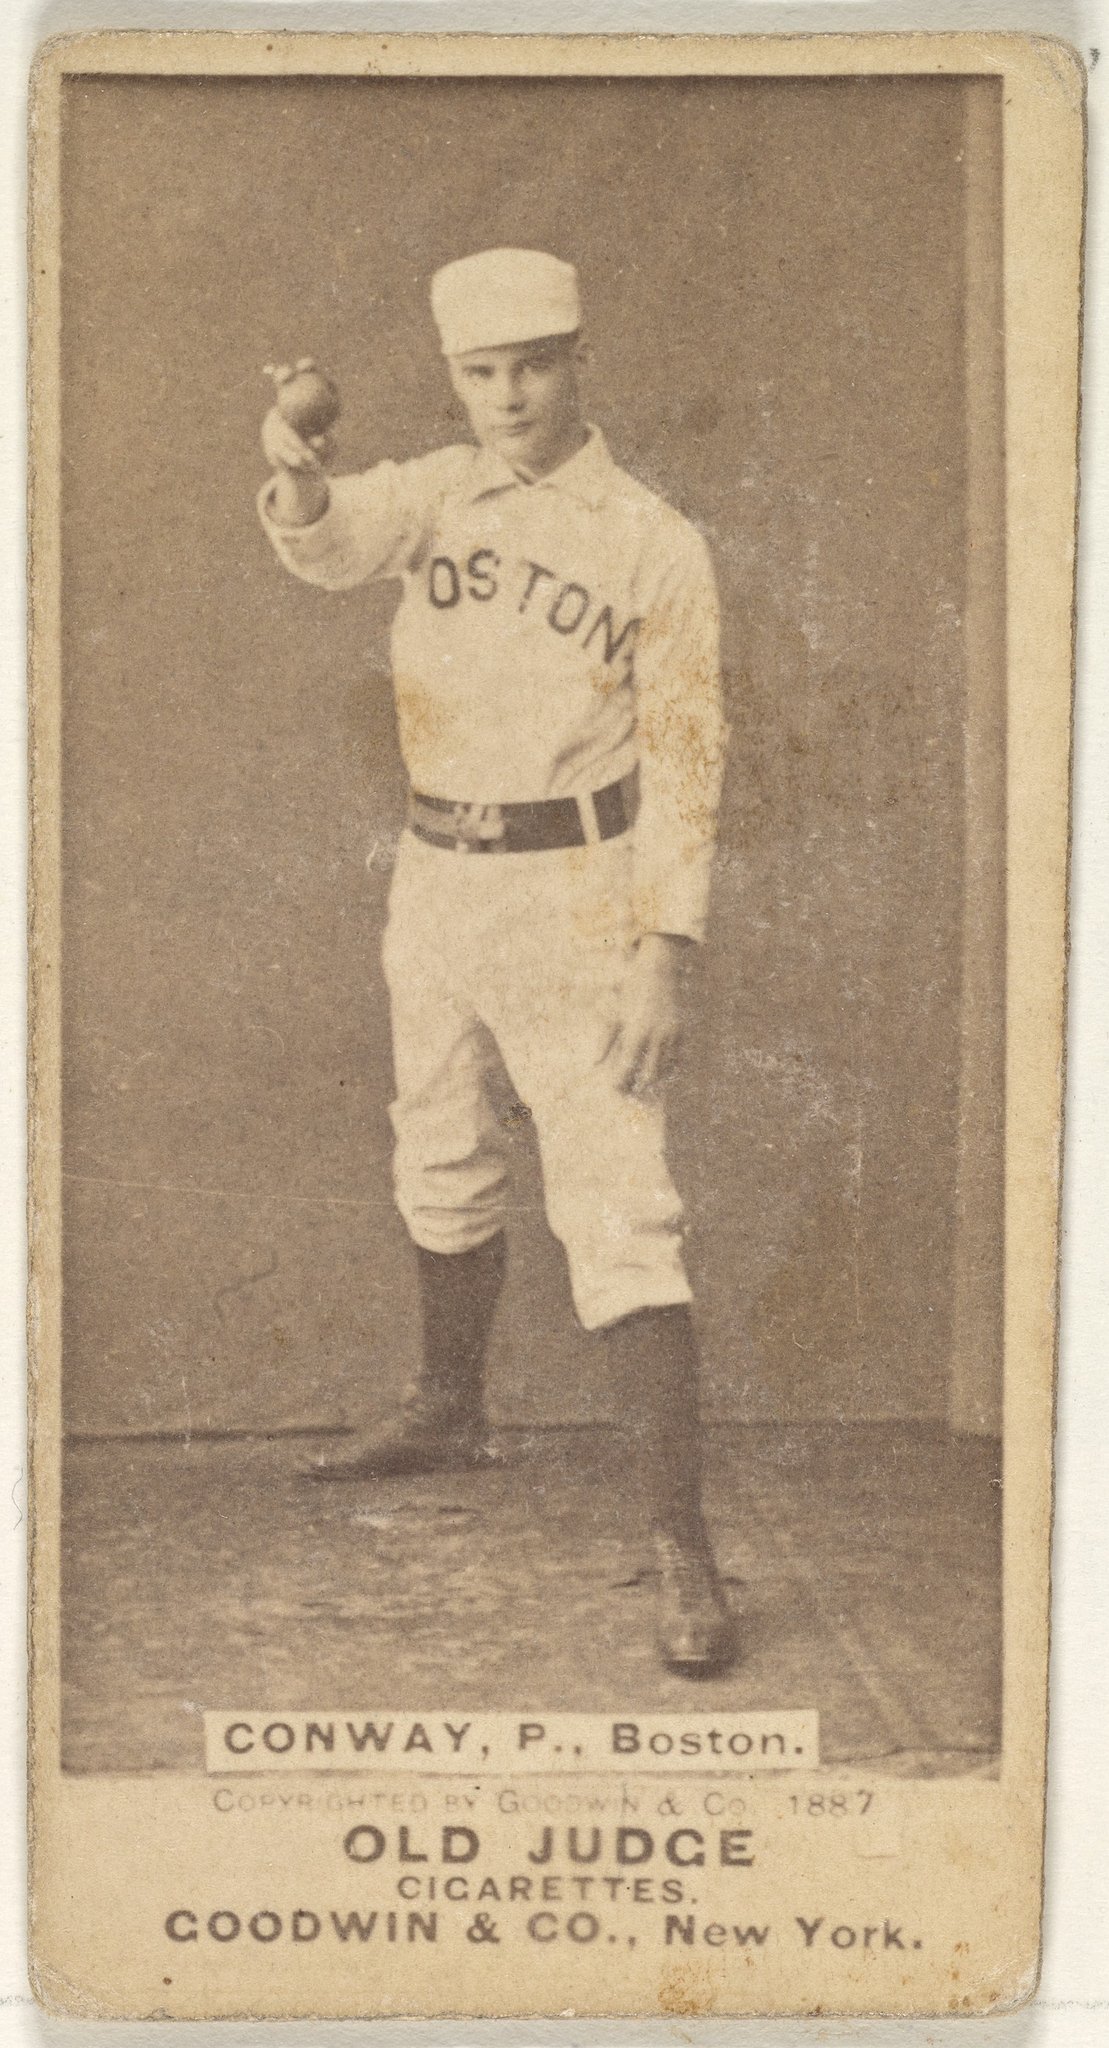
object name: baseball card, photograph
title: Conway, Pitcher, Boston, from the Old Judge series (N172) for Old Judge Cigarettes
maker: goodwin & company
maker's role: publisher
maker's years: 1850-1950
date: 1887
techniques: albumen silver print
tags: men,portraits,baseball,athletes